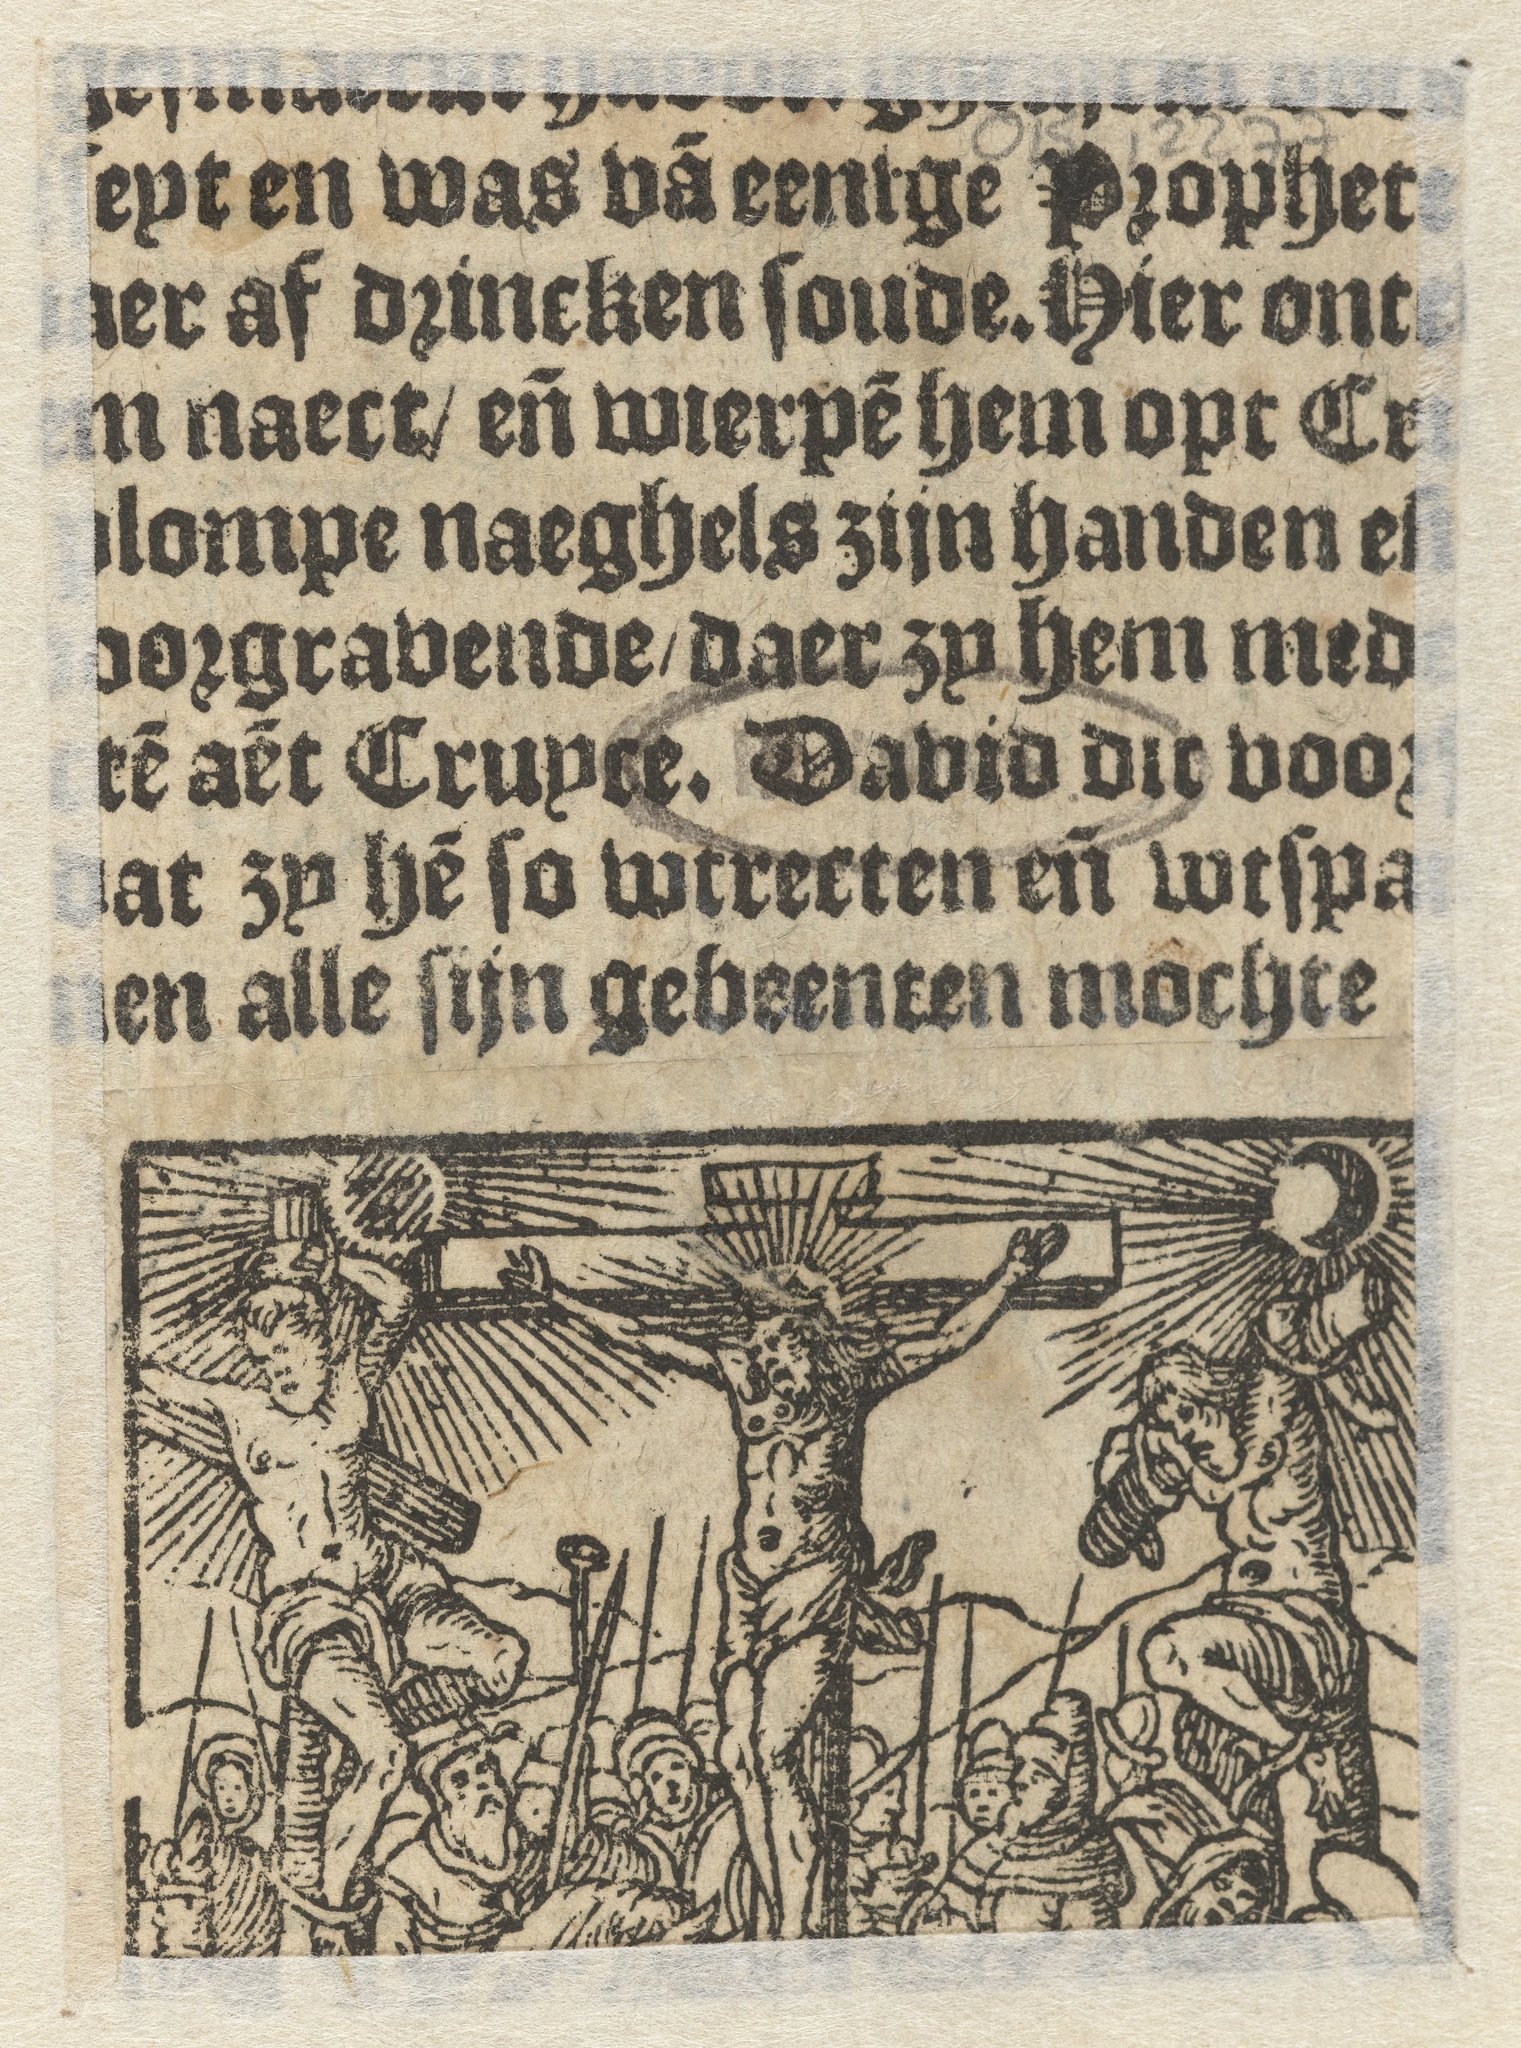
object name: print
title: Kruisiging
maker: Anonymous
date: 1604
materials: paper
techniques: woodcut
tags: sun and moon in the sky at either side of the cross of christ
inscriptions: collector's mark: Lugt 2228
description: Kruisigingsscène met Christus aan het kruis. Links en rechts van hem de twee gekruisigde moordenaars. Zon en maan aan de hemel. Aan de voet van het kruis omstanders.